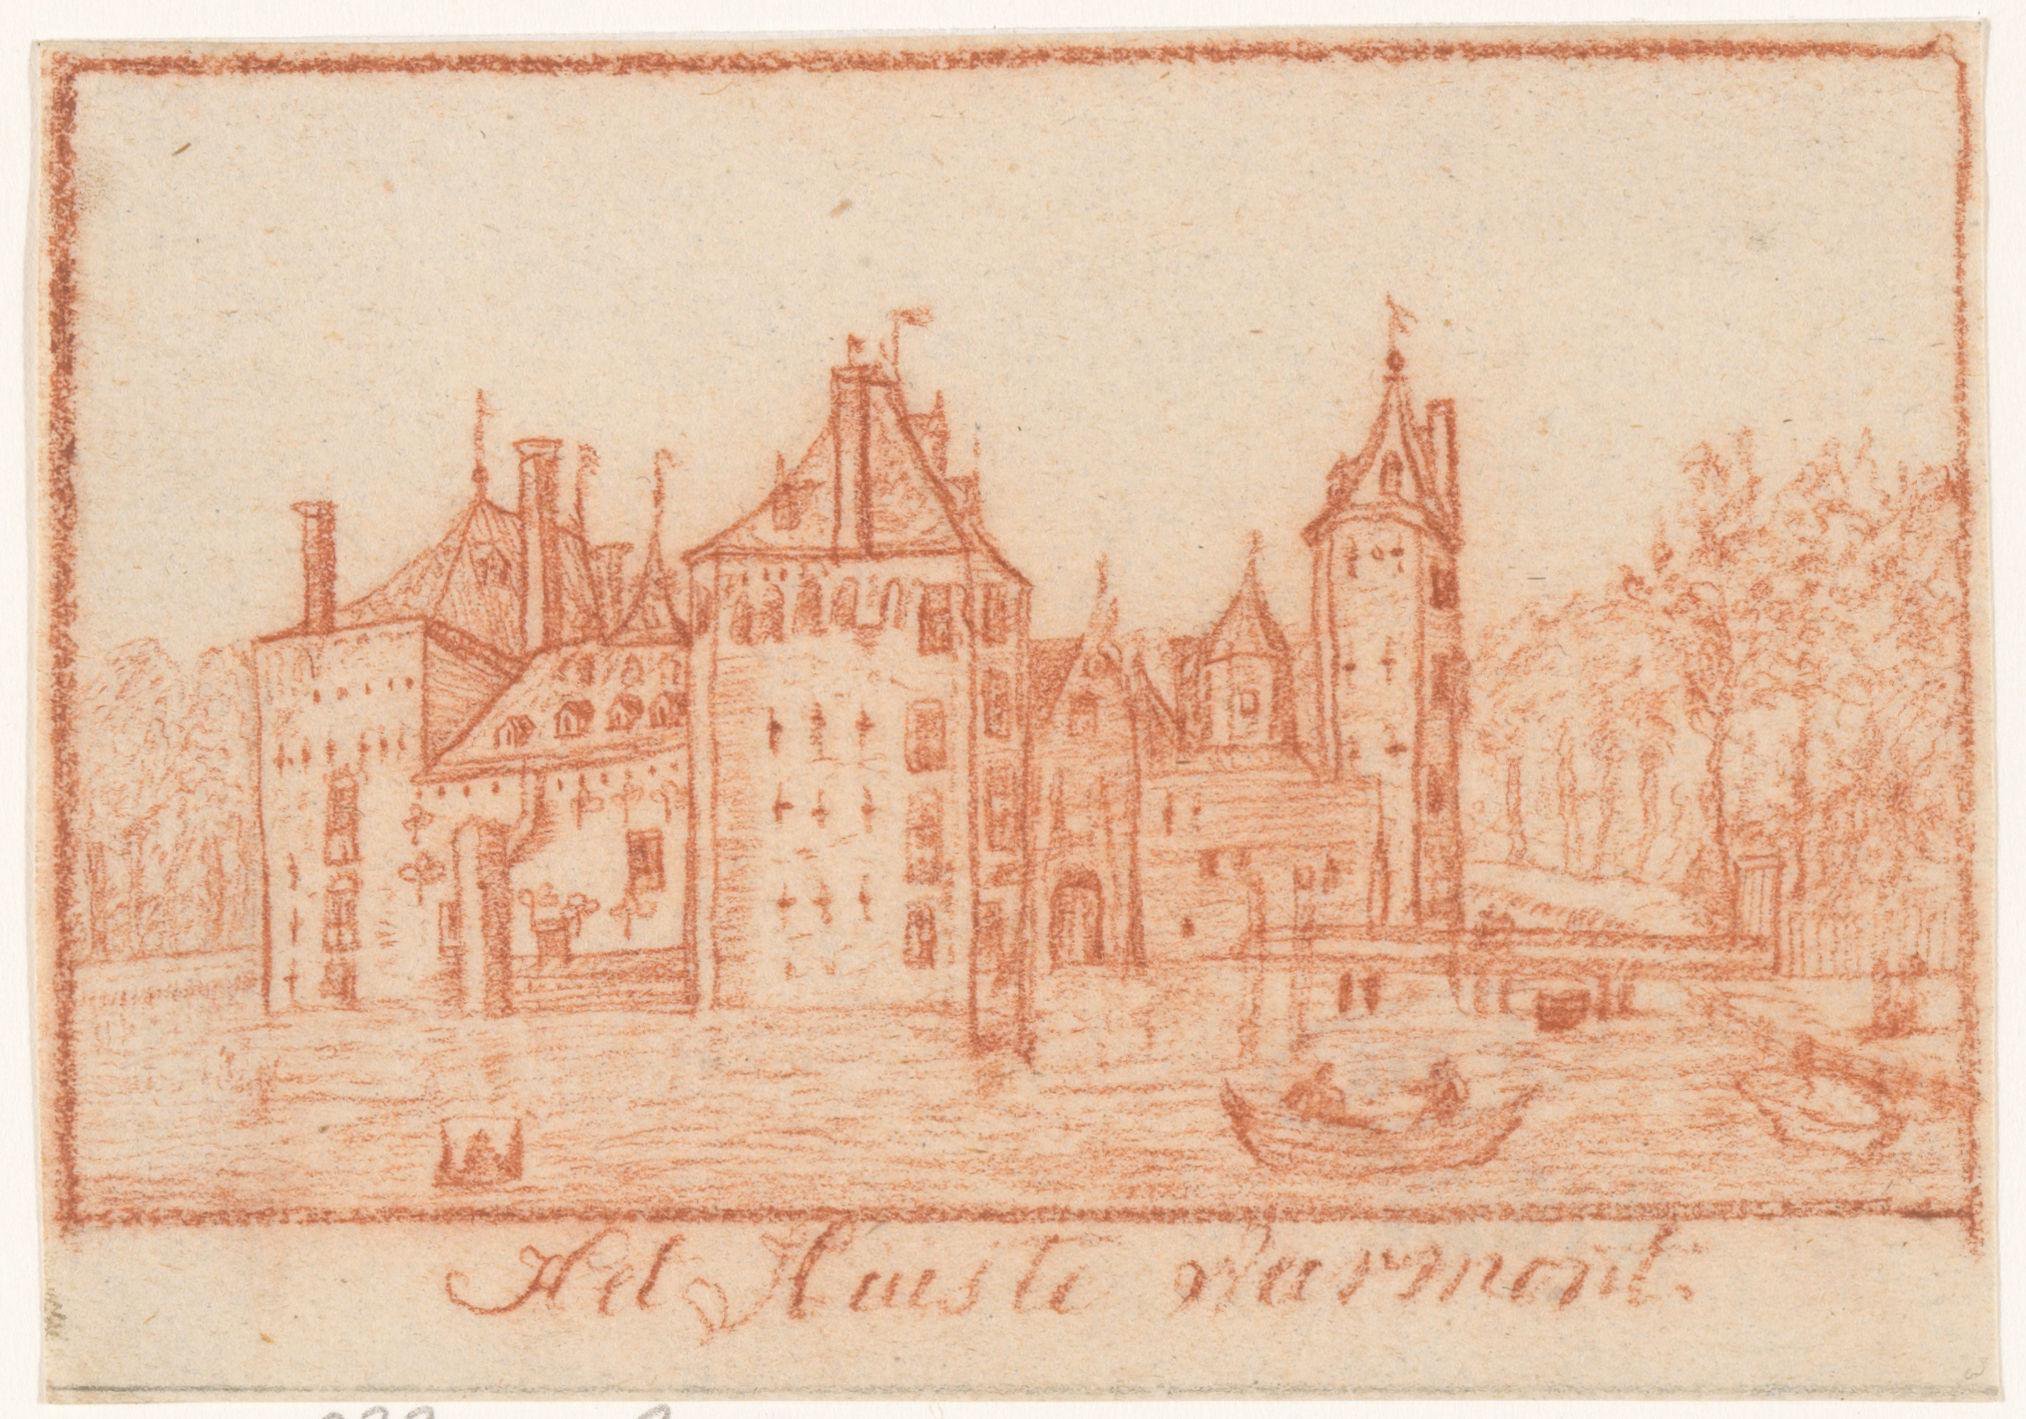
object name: drawing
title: Het Huis te Warmont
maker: Anonymous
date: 1725-1799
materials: chalk, paper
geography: amsterdam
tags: castle, fisherman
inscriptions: collector's mark: Lugt 2228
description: Gezicht op het kasteel Huis Warmond te Warmond, in de situatie omstreeks 1611. Op de voorgrond in de slotgracht een boot met twee vissers.